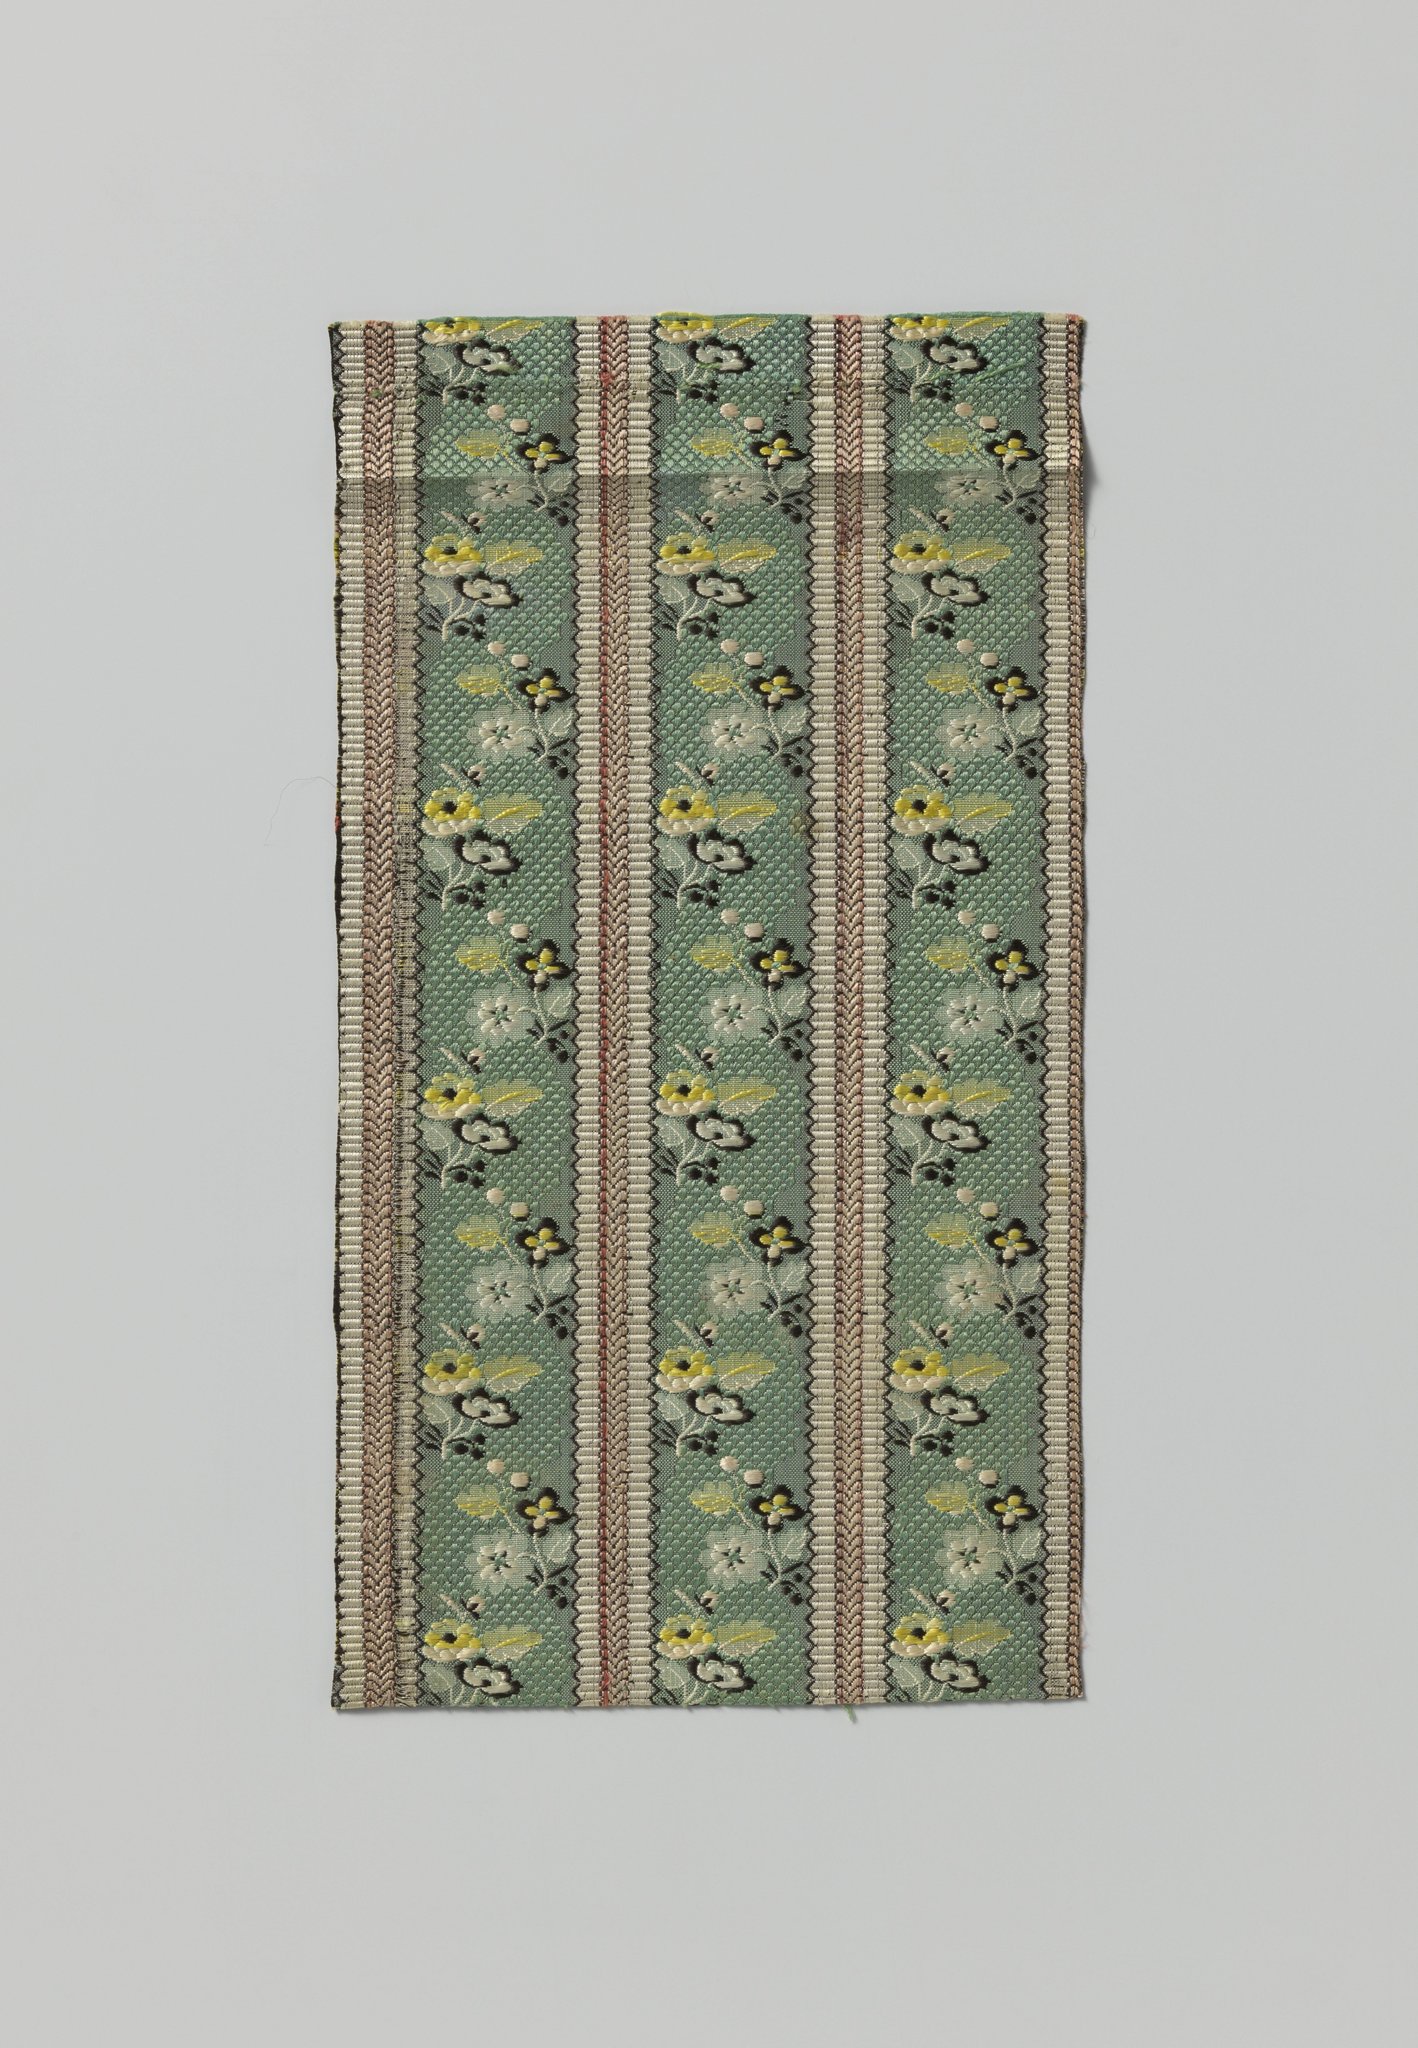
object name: fragment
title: Fragment veelkleurige zijden droguet liseré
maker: Anonymous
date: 1750-1800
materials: silk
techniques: droguet liseré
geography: germany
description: Een fragment veelkleurig zijdeweefsel. Het patroon heeft strepen in rood, wit en zwart waartussen strepen gevuld met een fijngeruite, groene slinger met in elke bocht een bloemtak in geel, wit en groen.